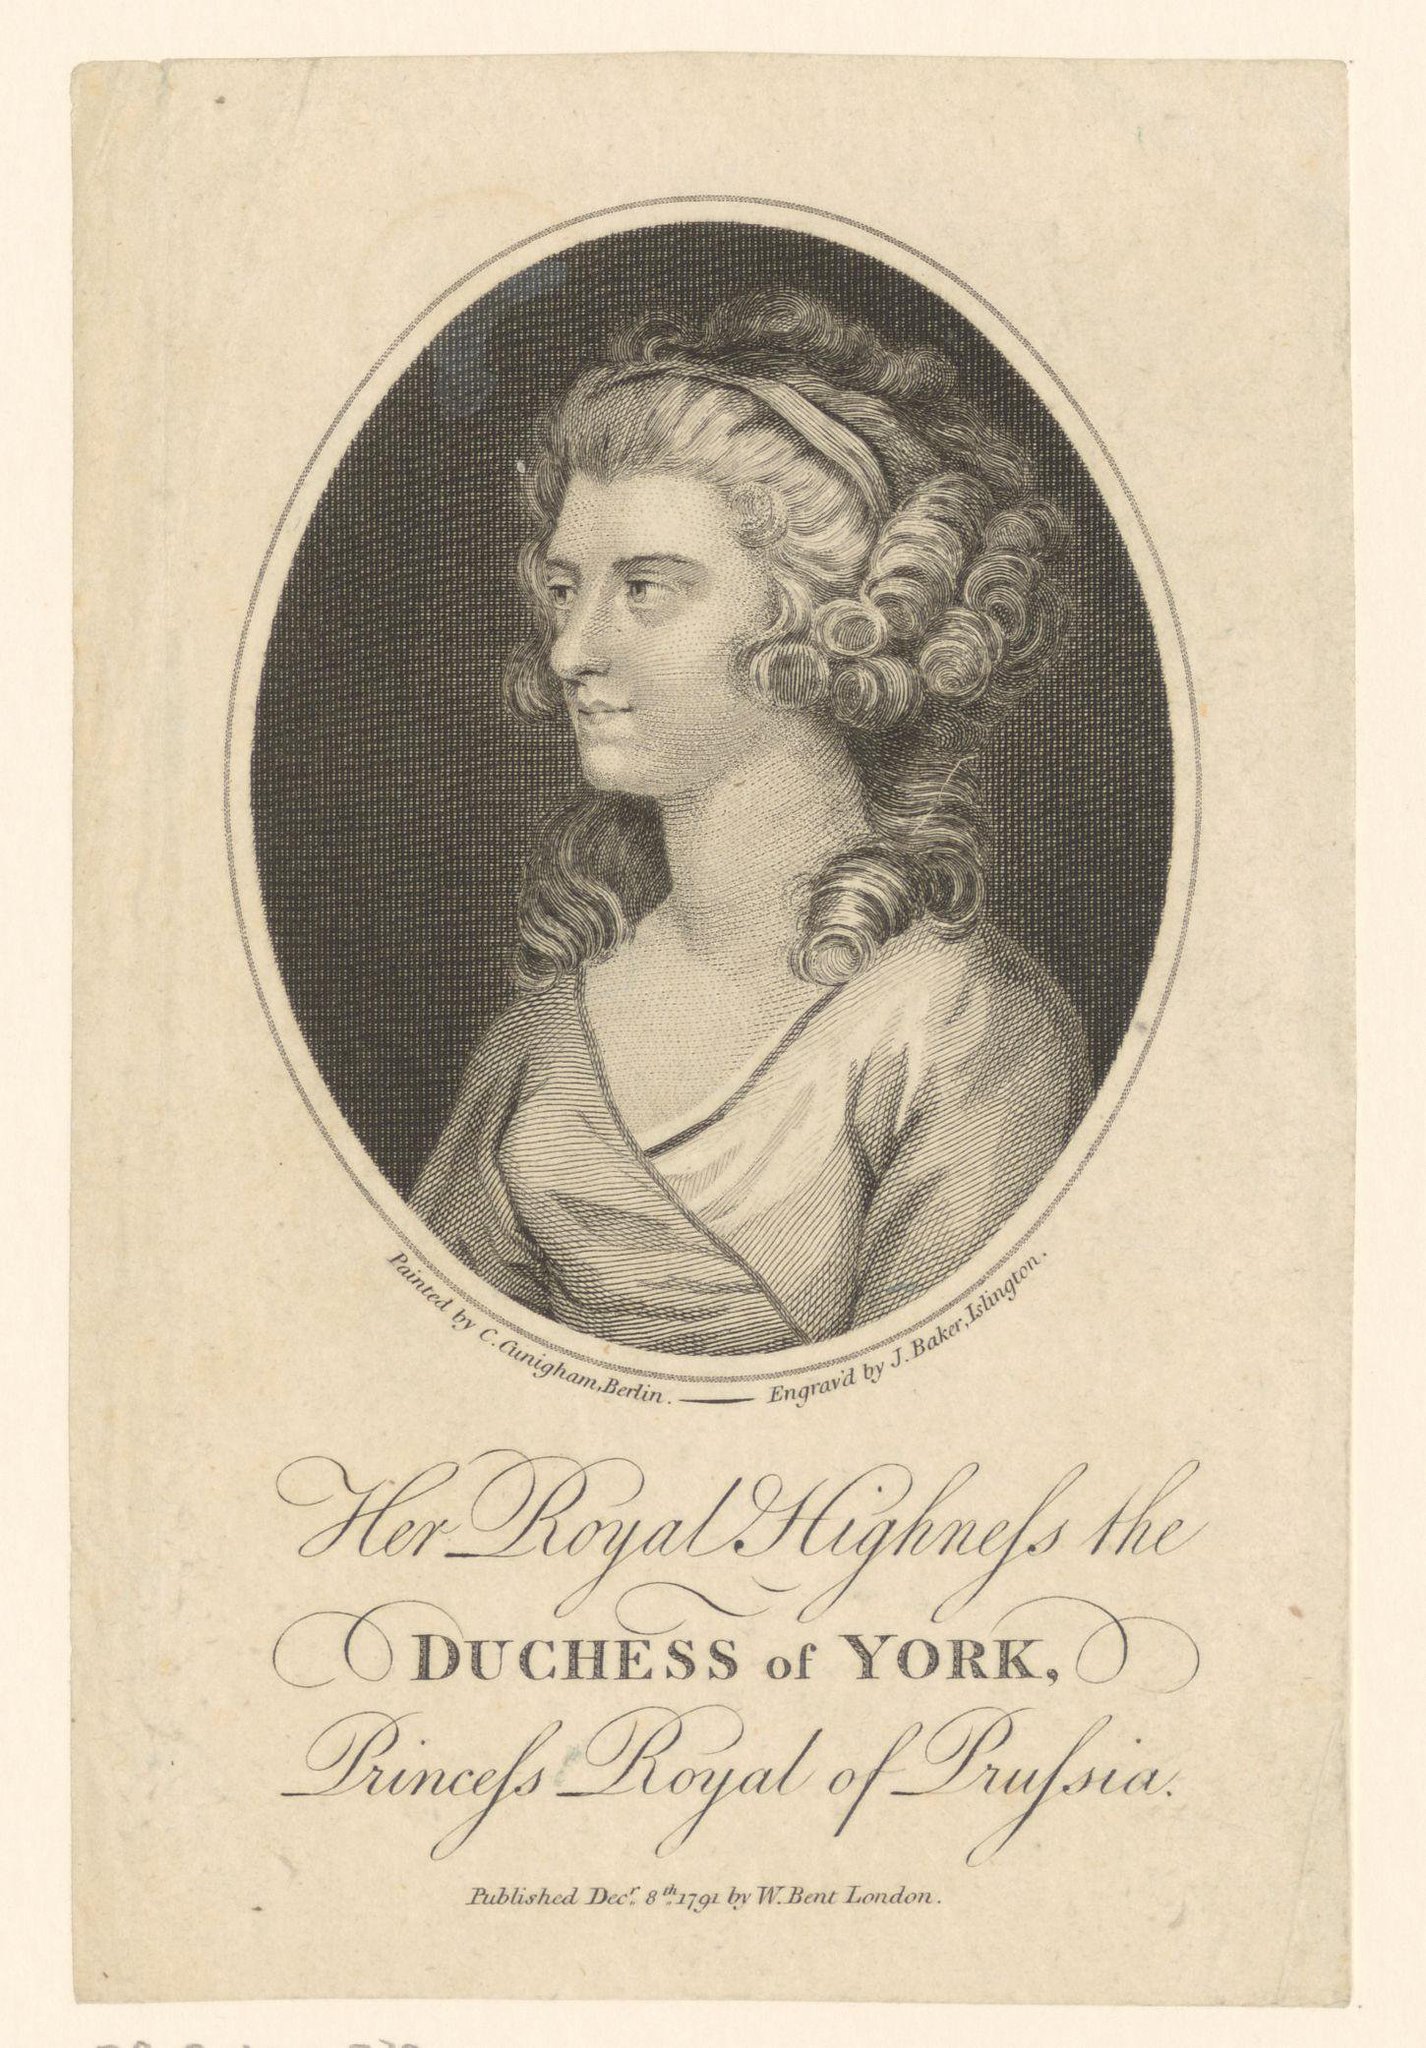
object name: print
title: Her Royal Highness the Duchess of York, Princess Royal of Prussia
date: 1712-1791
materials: paper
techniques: engraving, etching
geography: london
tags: frederika van pruisen, historical persons, princess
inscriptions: collector's mark: Lugt 2228